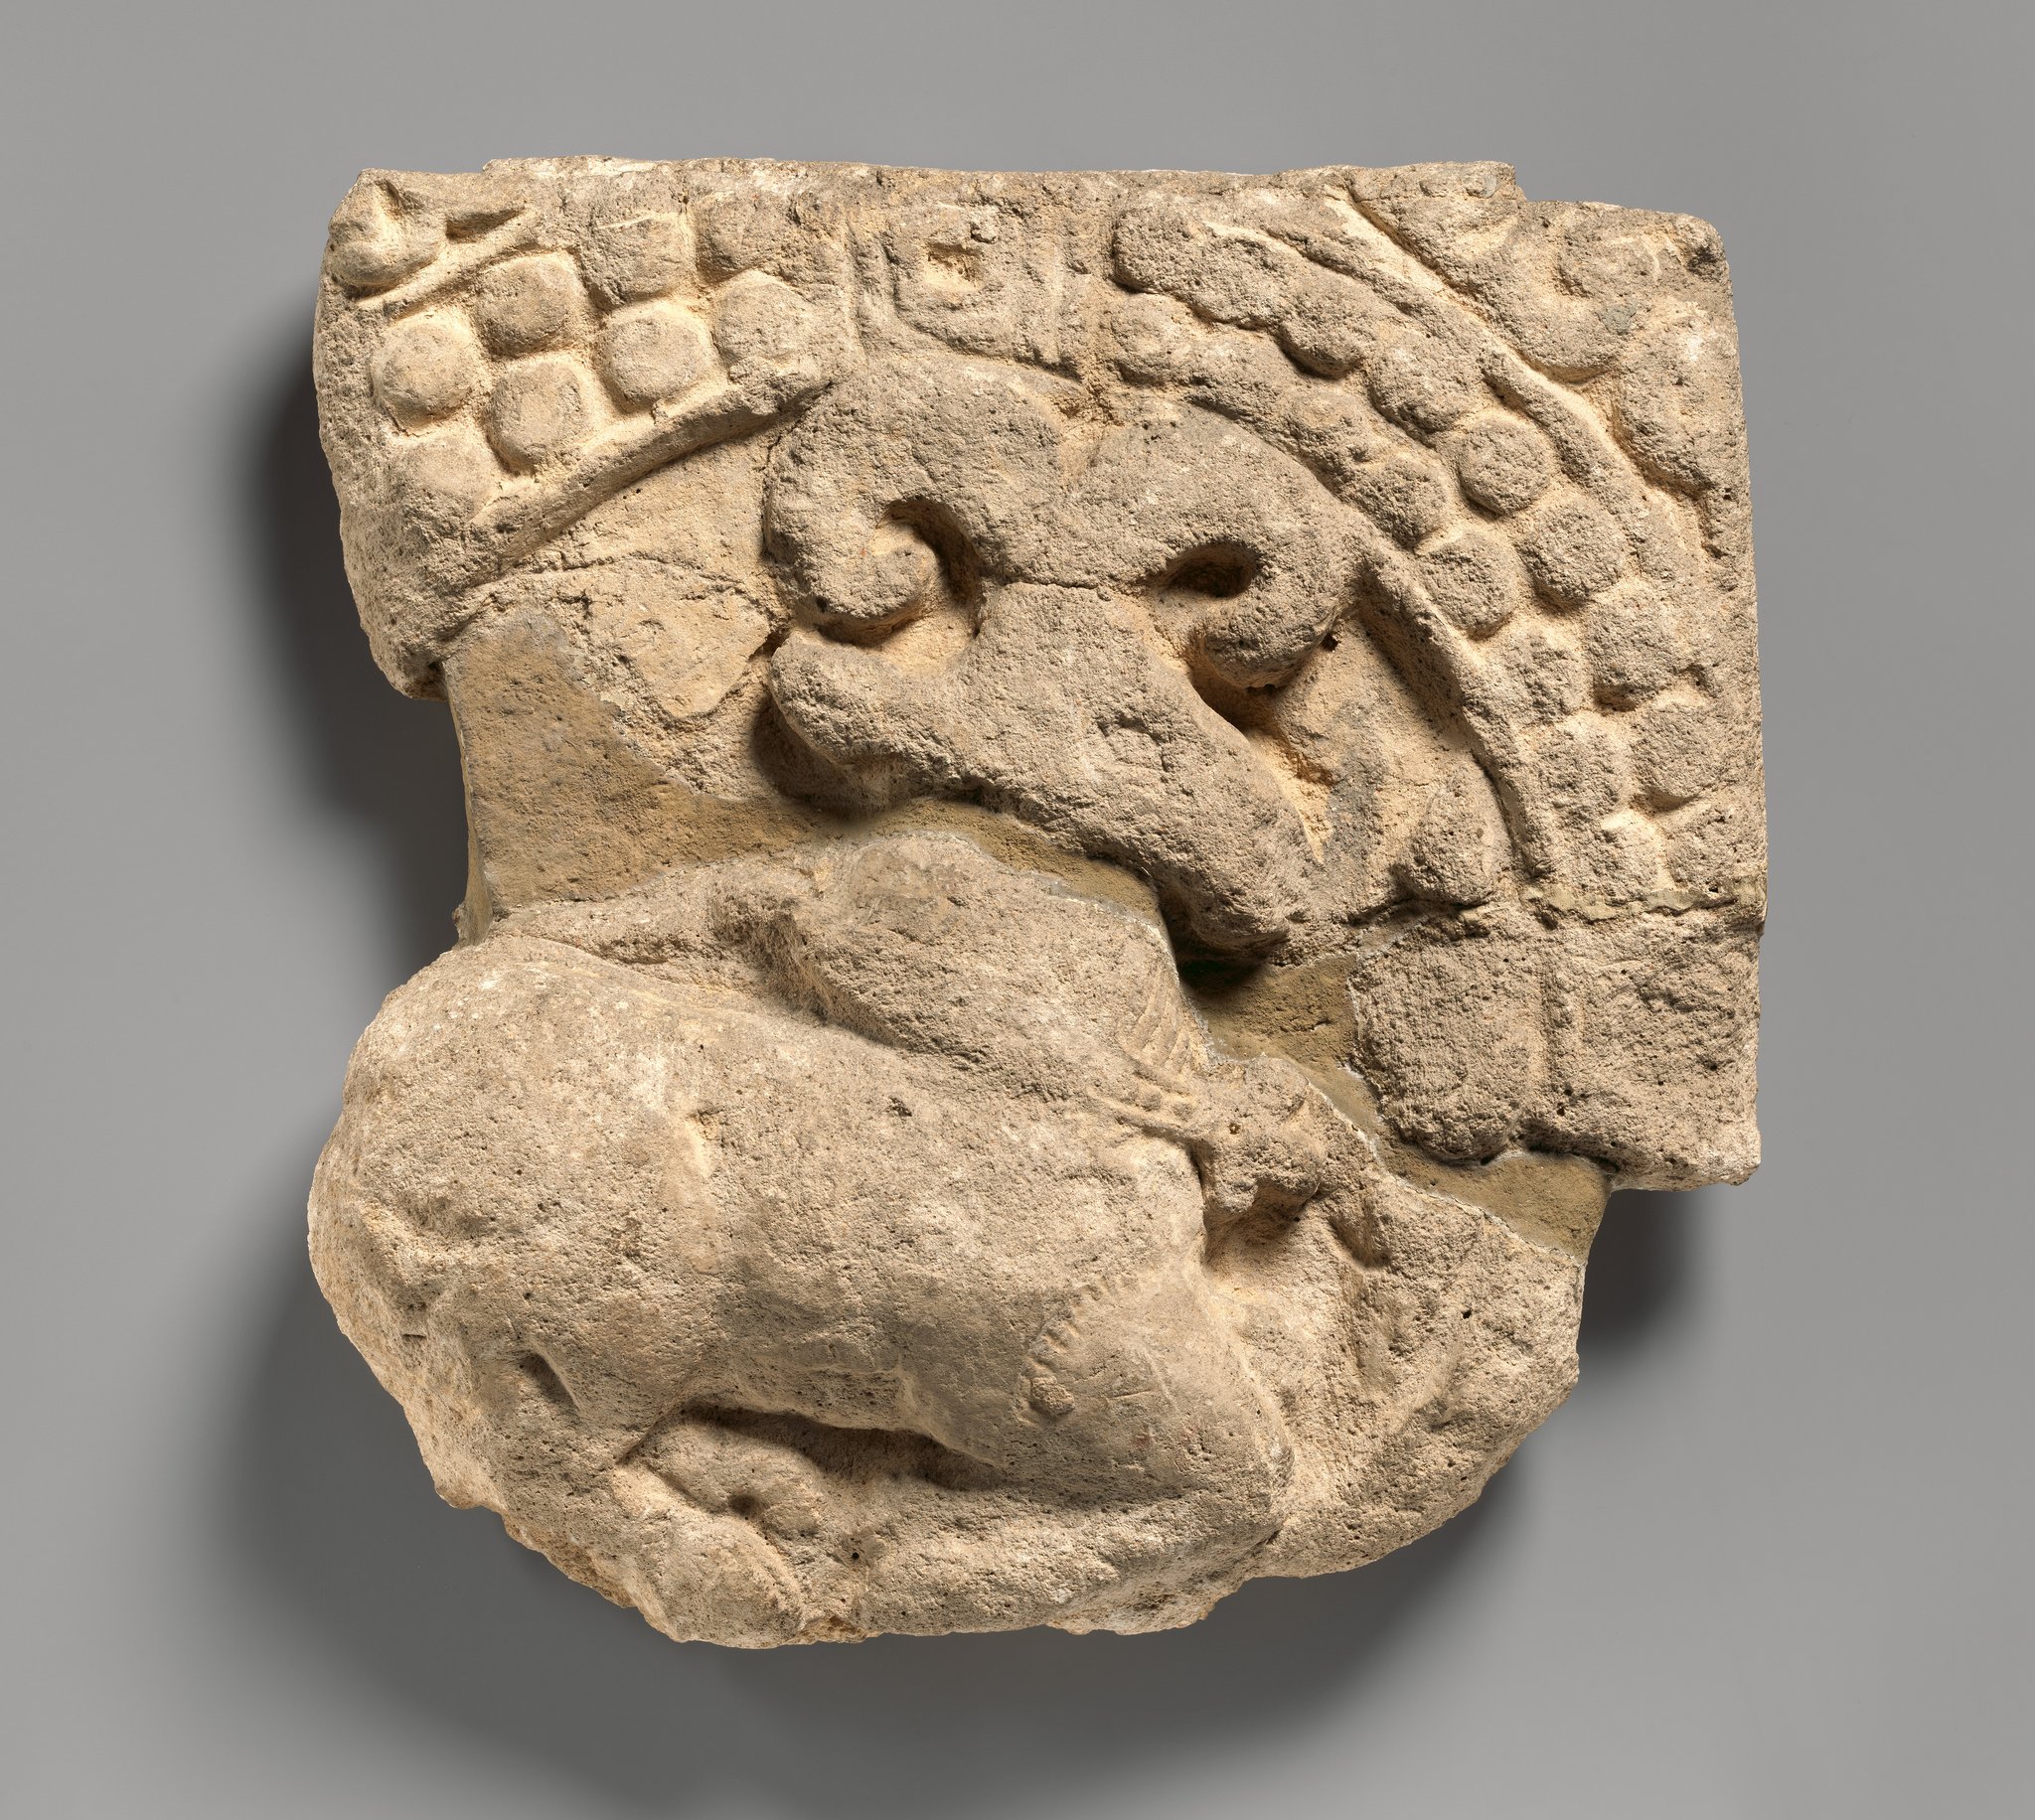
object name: relief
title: Wall panel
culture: sasanian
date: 501-600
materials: plaster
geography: mesopotamia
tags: rams